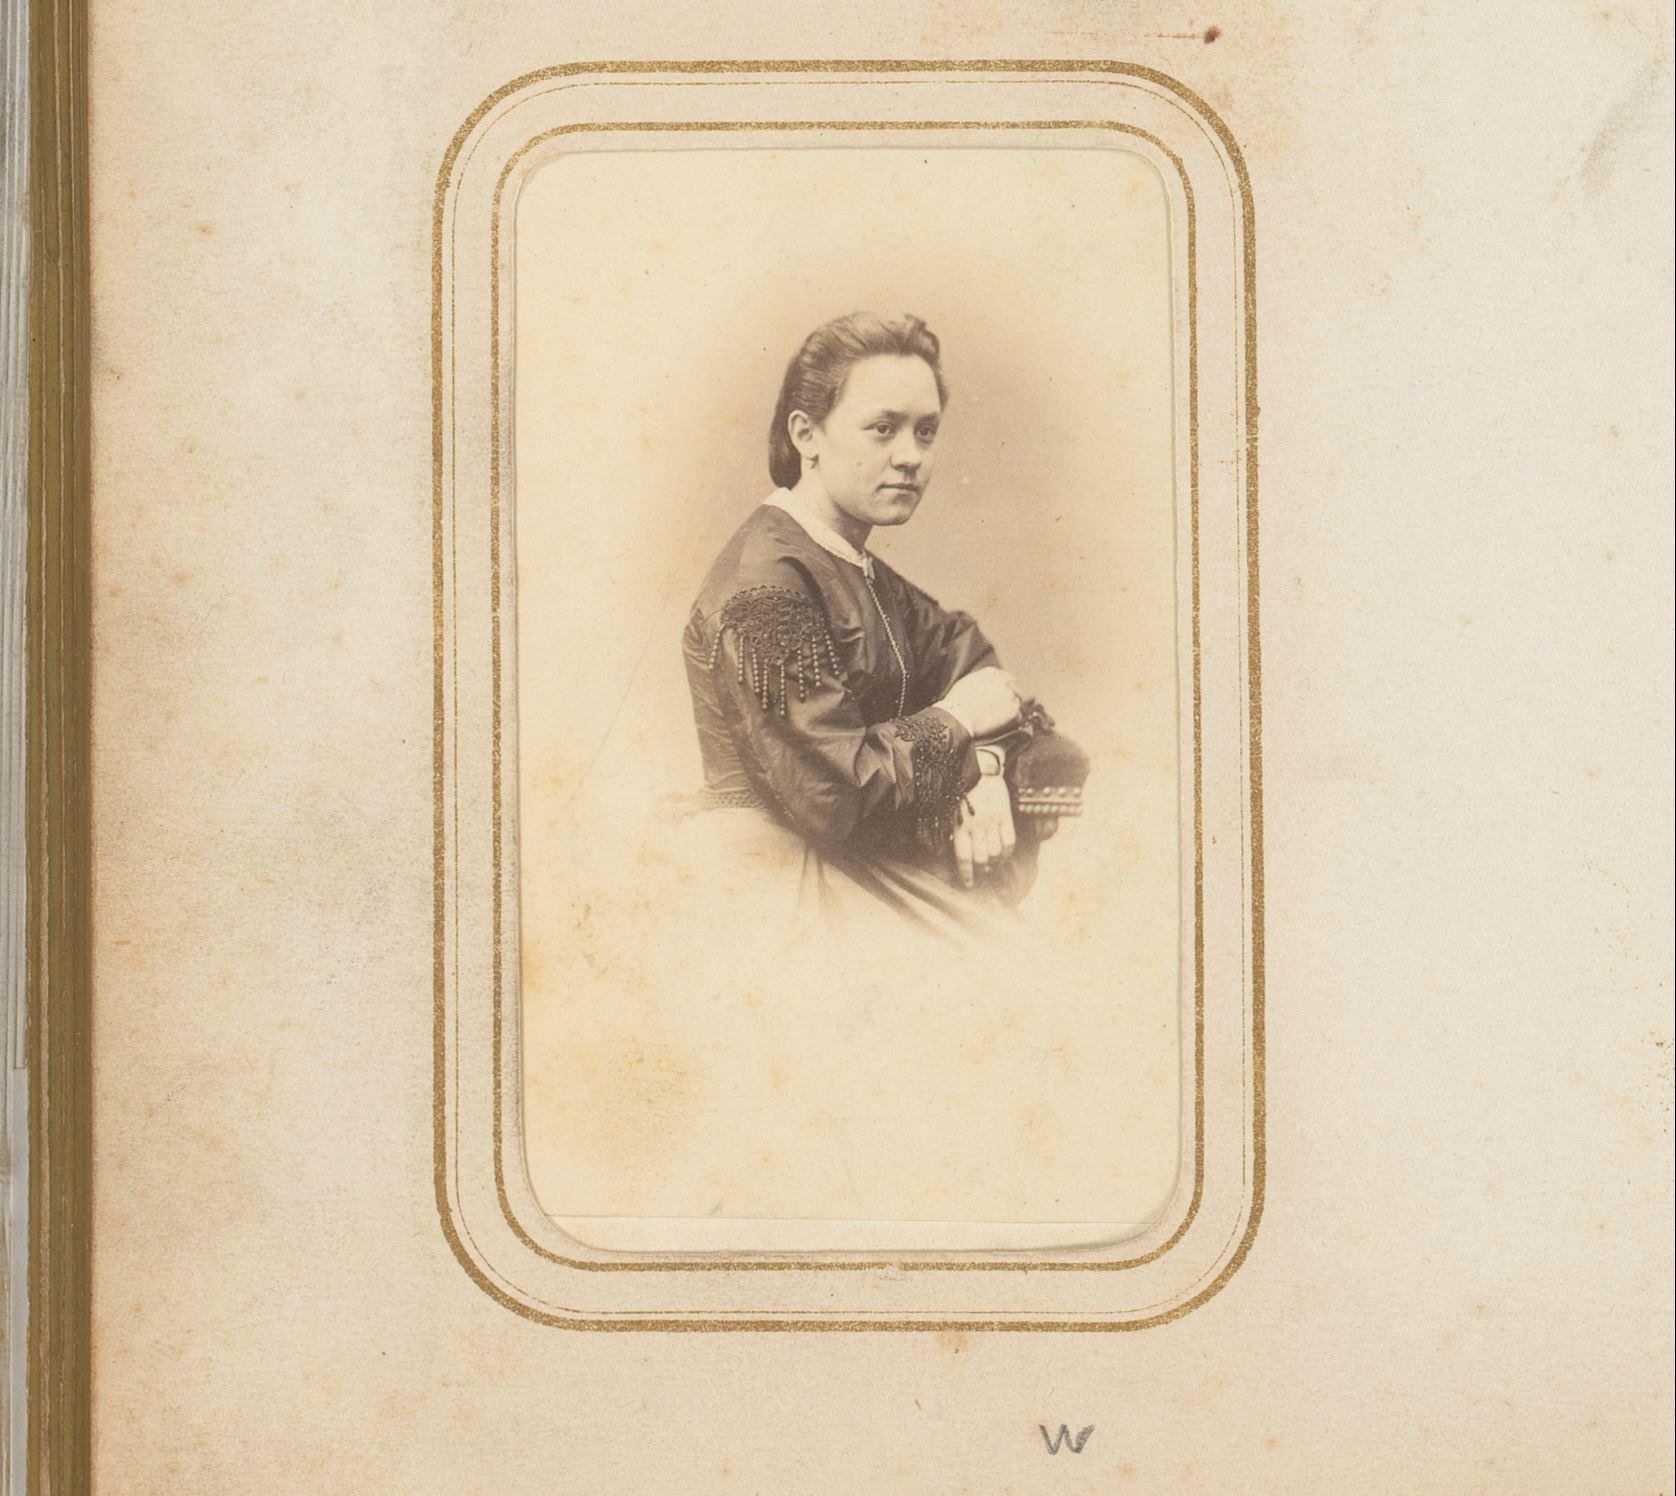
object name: album leaf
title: Portret van een jonge vrouw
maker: albert greiner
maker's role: fotograaf, fotostudio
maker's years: 1833-1890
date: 1861-1874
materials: cardboard, photographic support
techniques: albumen print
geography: amsterdam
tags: adolescent, young woman, maiden, historical persons - bb - woman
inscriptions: inscription: ‘A. Greiner/ Photograf/ Nieuwendijk L.87/ Amsterdam’